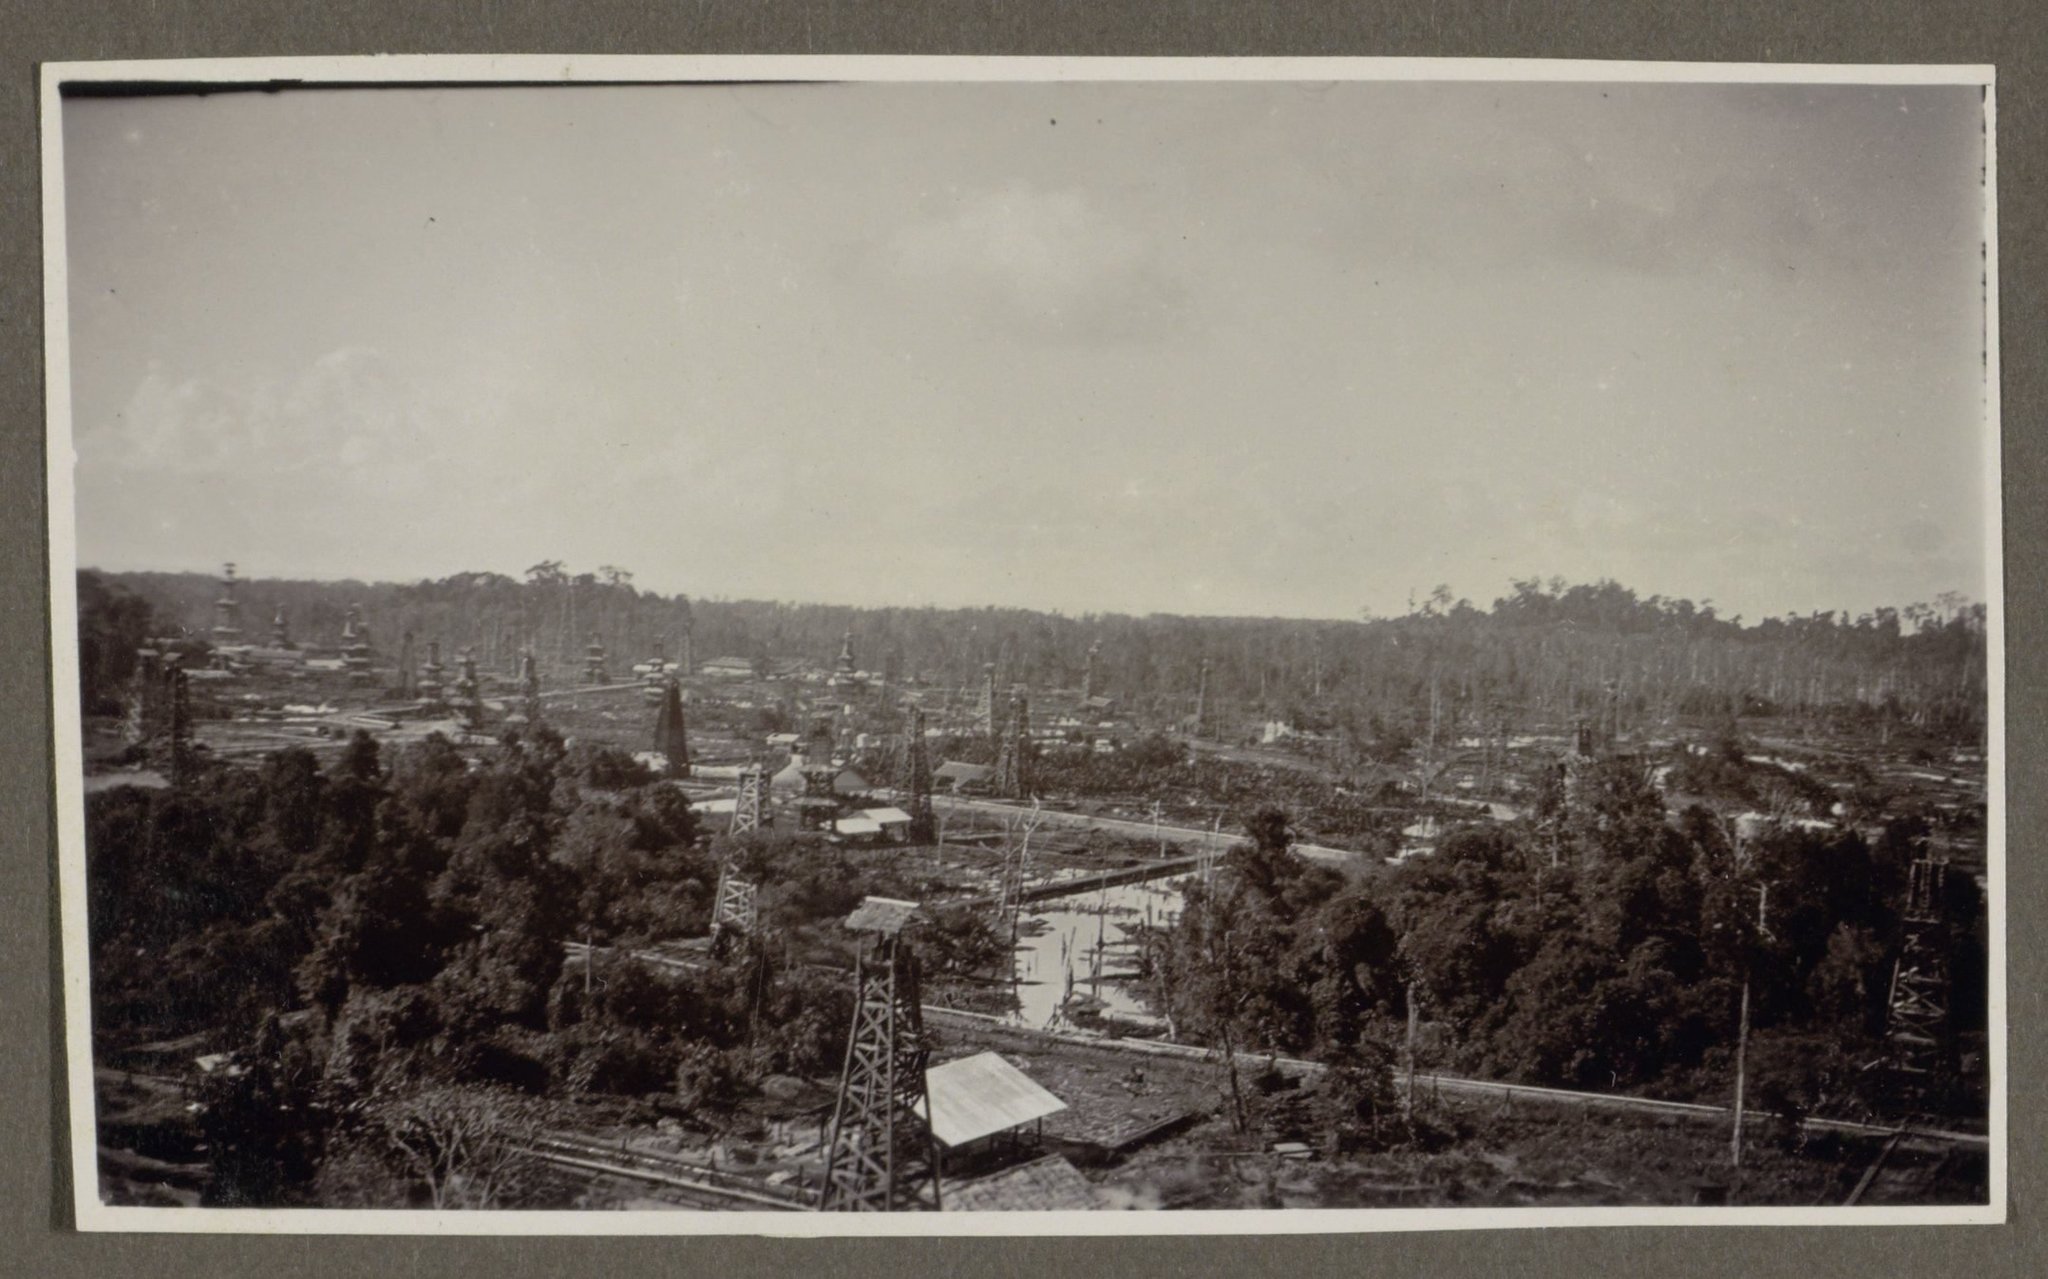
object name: photograph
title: Overzicht van boortorens en gebouwen temidden van bomen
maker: Anonymous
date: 1920-1930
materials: photographic support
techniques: gelatin silver print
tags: drilling for oil, dutch east indies, the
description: Onderdeel van familiealbum Nederlands-Indië.